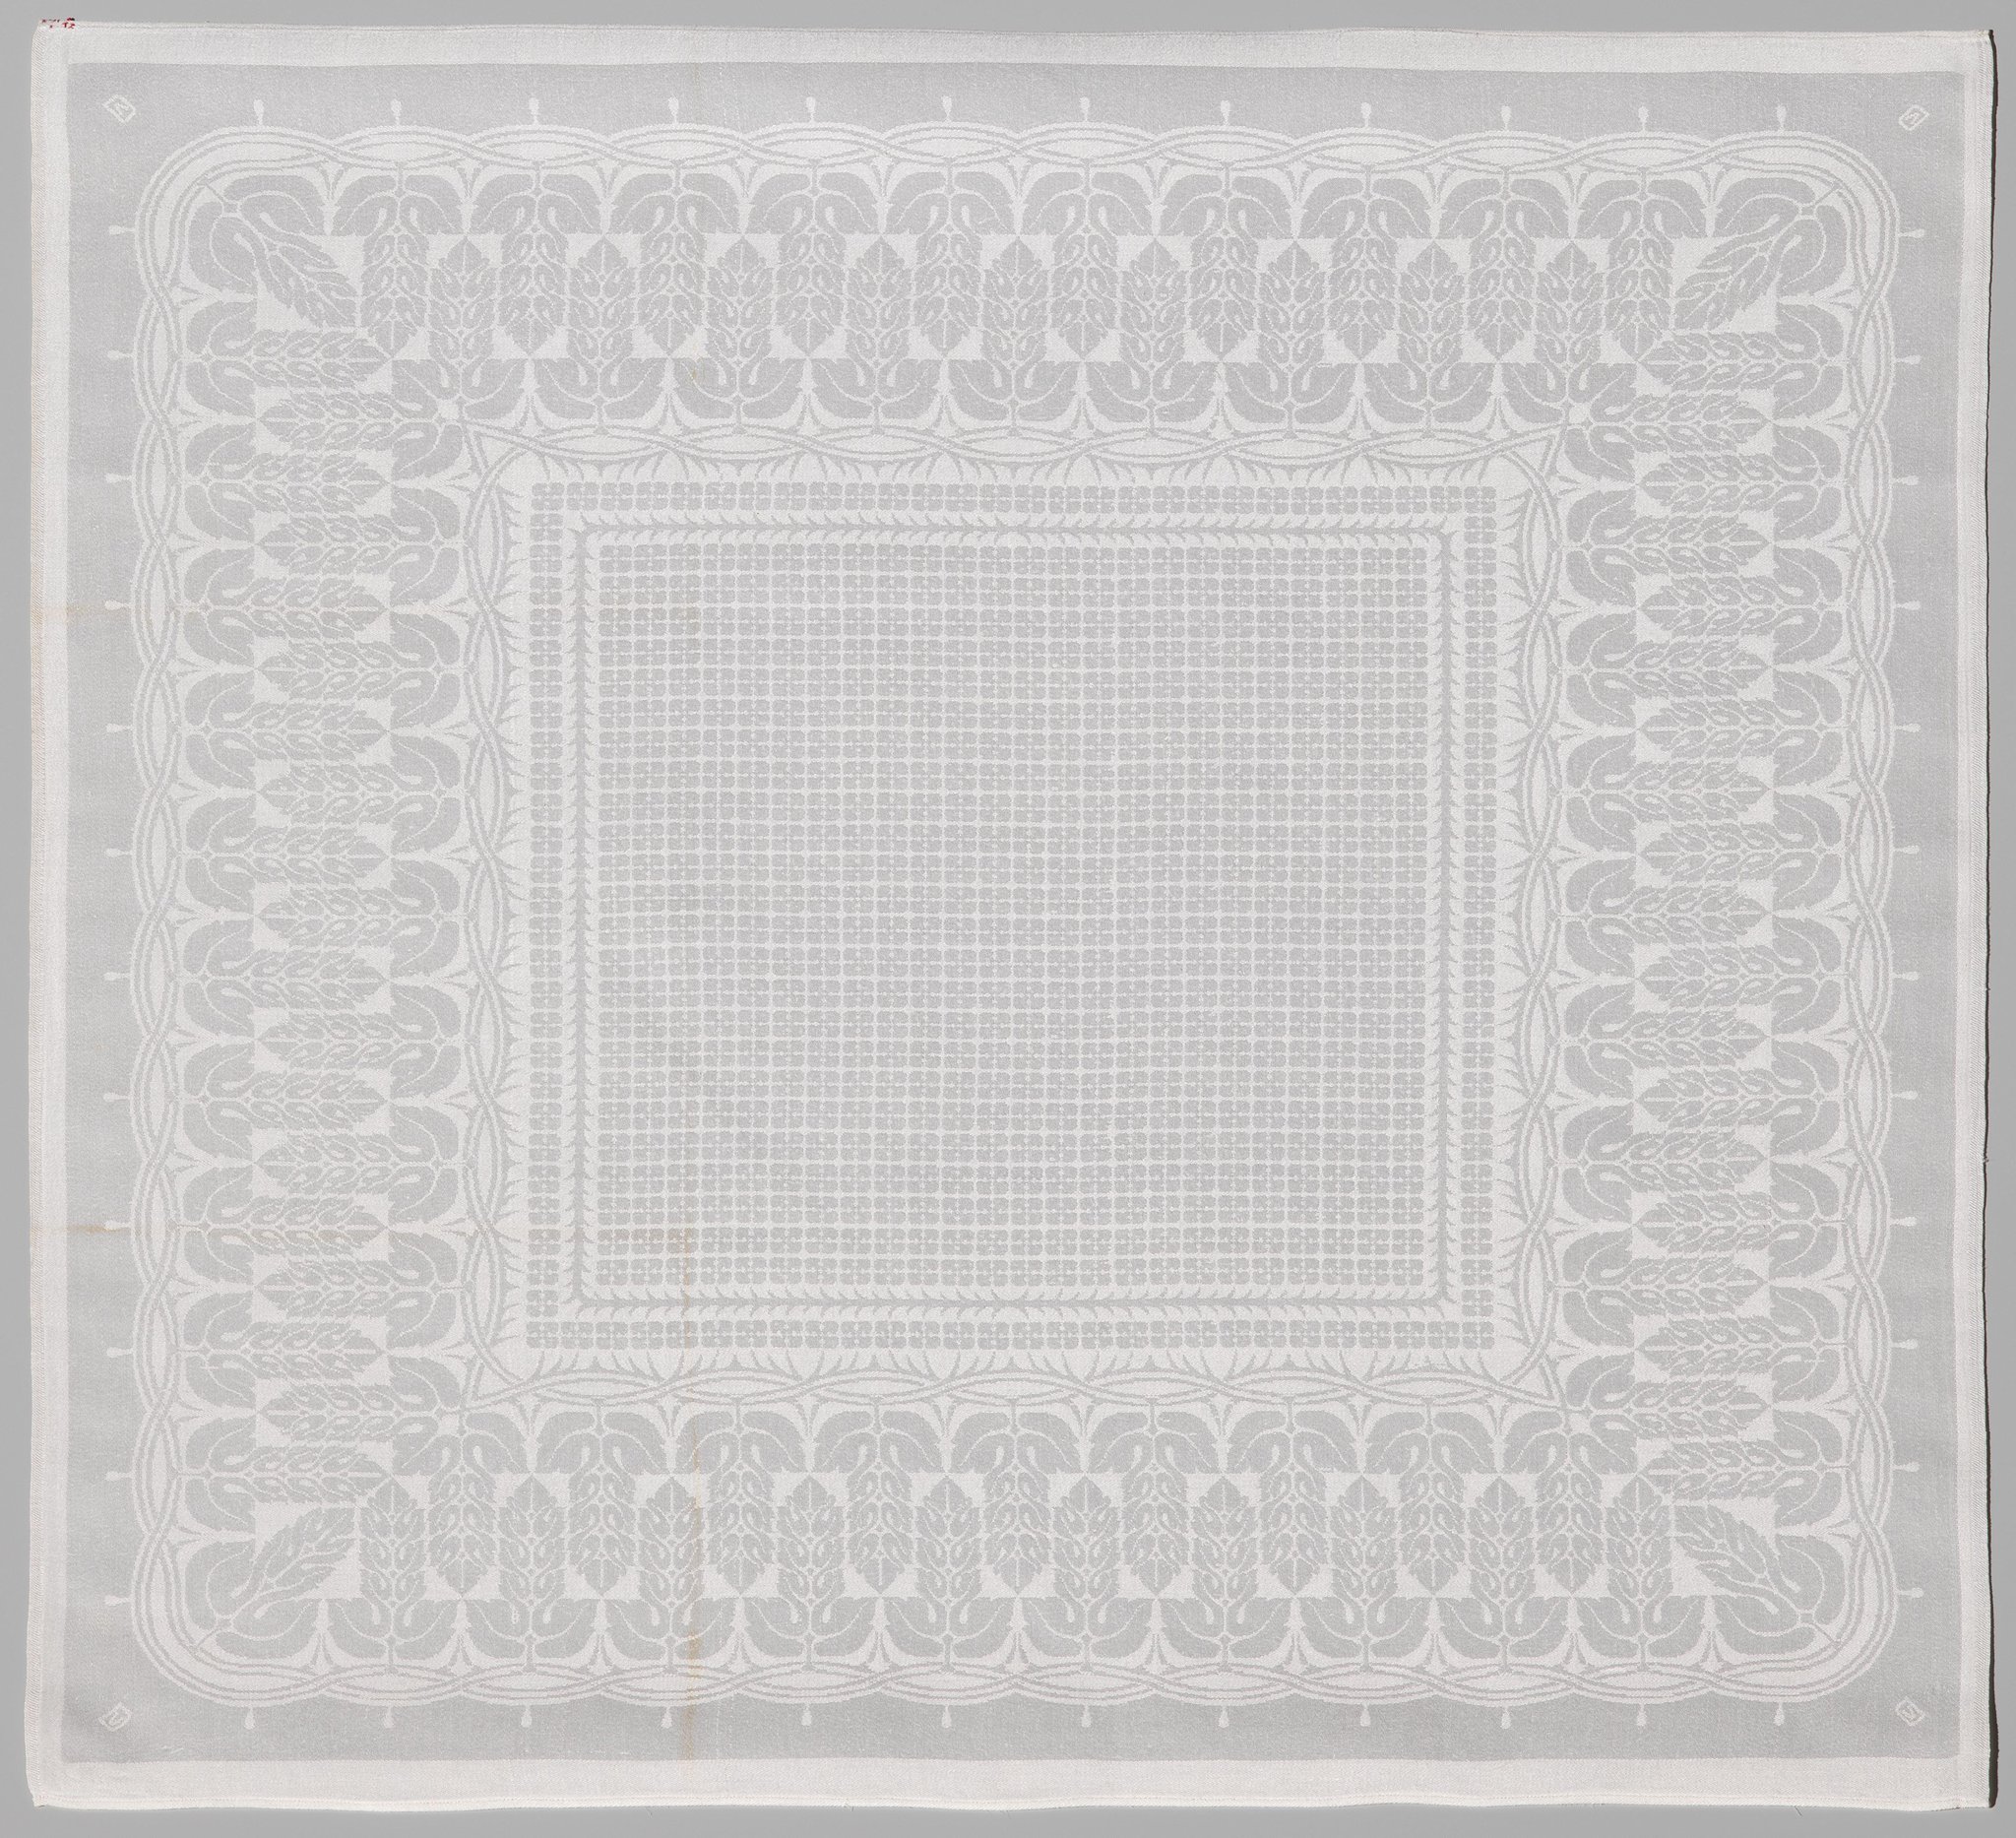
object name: napkin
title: Servet van linnendamast met meidoorns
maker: chris lebeau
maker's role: draughtsman, print maker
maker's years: 1878-1945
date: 1900-1925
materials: linen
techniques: damask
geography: eindhoven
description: Wit linnen damasten servet met een dessin van meidoorns. In rood gestikt: 12.